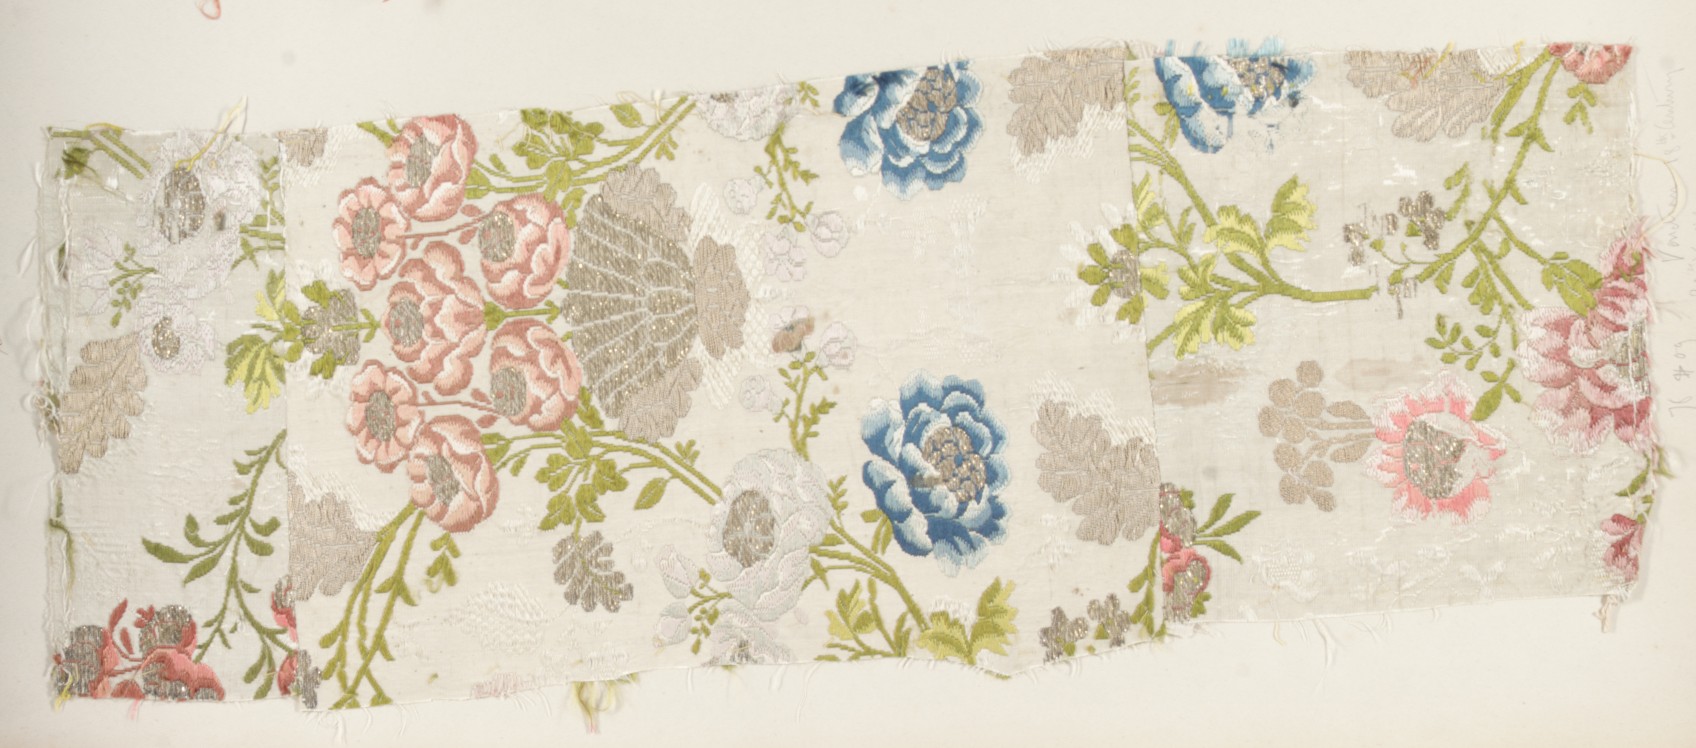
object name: fragment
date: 1701-1800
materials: metal thread, silk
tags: flowers,leaves